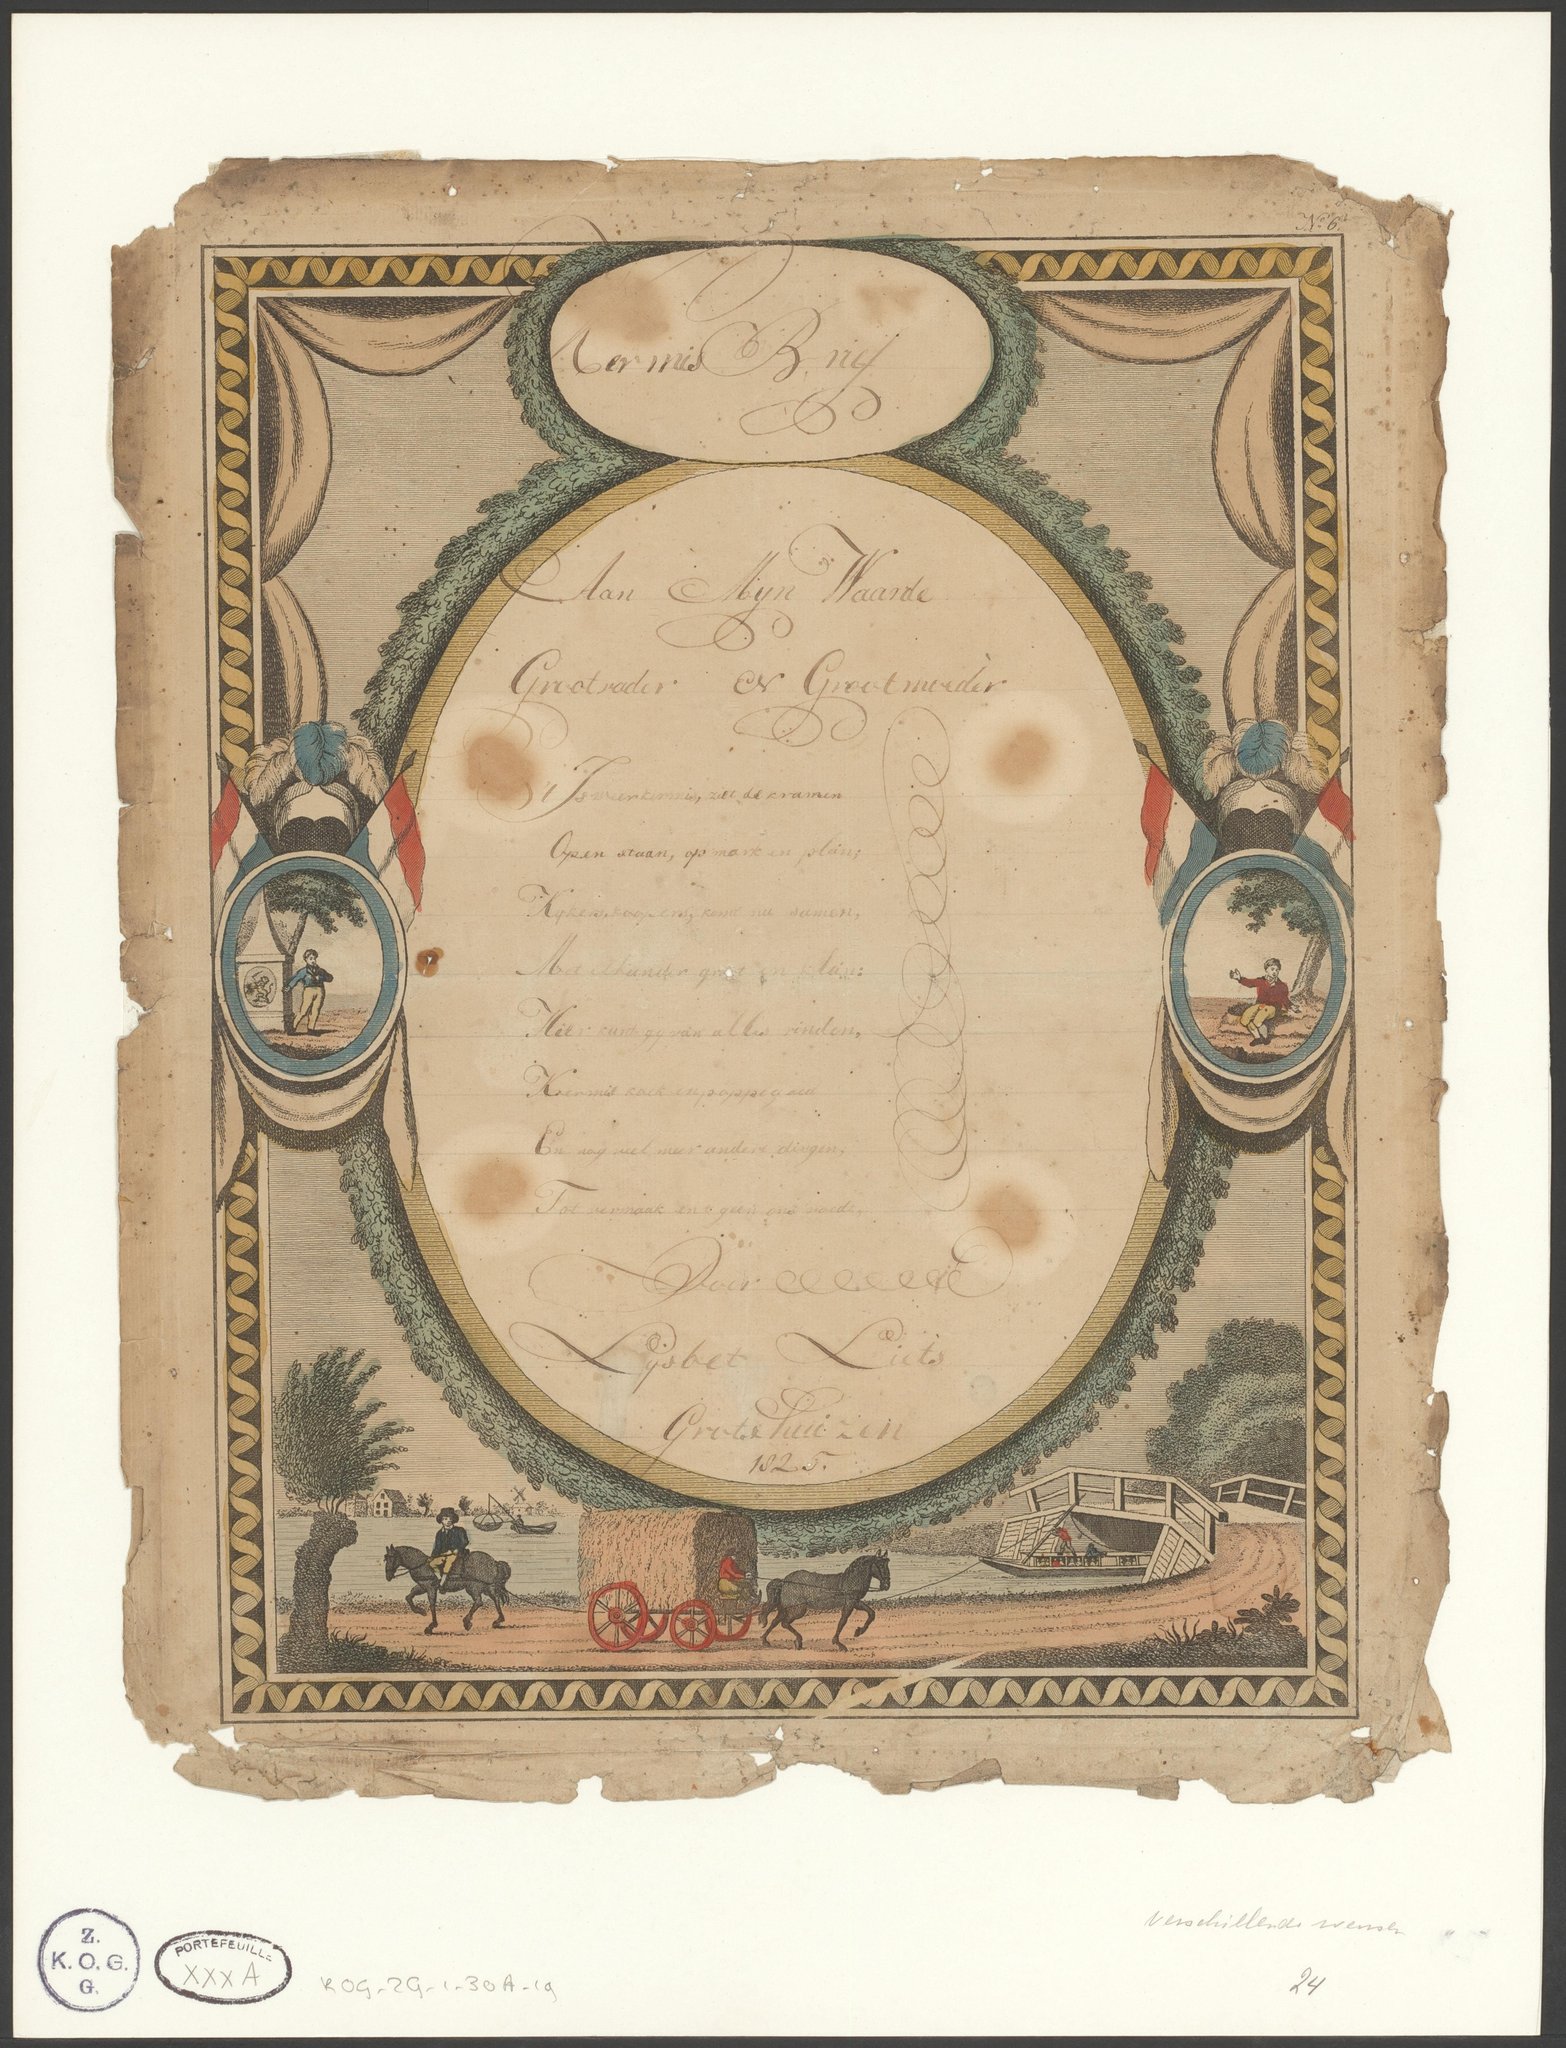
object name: print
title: Kermiswens van Lijsbet Liets, 1825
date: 1825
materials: ink, paper, watercolor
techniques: etching, hand coloring, writing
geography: netherlands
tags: tow-boat, towing-barge, pleasure fair and circus, hay-wagon, flag, colours (as symbol of the state, etc.)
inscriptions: collector's mark, collector's mark: Lugt 1641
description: Kermisbrief van Lijsbet Liets, 1825. Gericht aan haar grootouders. Handgeschreven vers binnen een voorgedrukte omlijsting met cartouches met vlaggen en trekschuit en hooiwagen op een weg langs het water. Genummerd rechtsboven: No. 6. Onderwerpsrubrieken binnen de Atlas Zeden en Gewoonten: Nieuwjaars- en kermiswenschen.